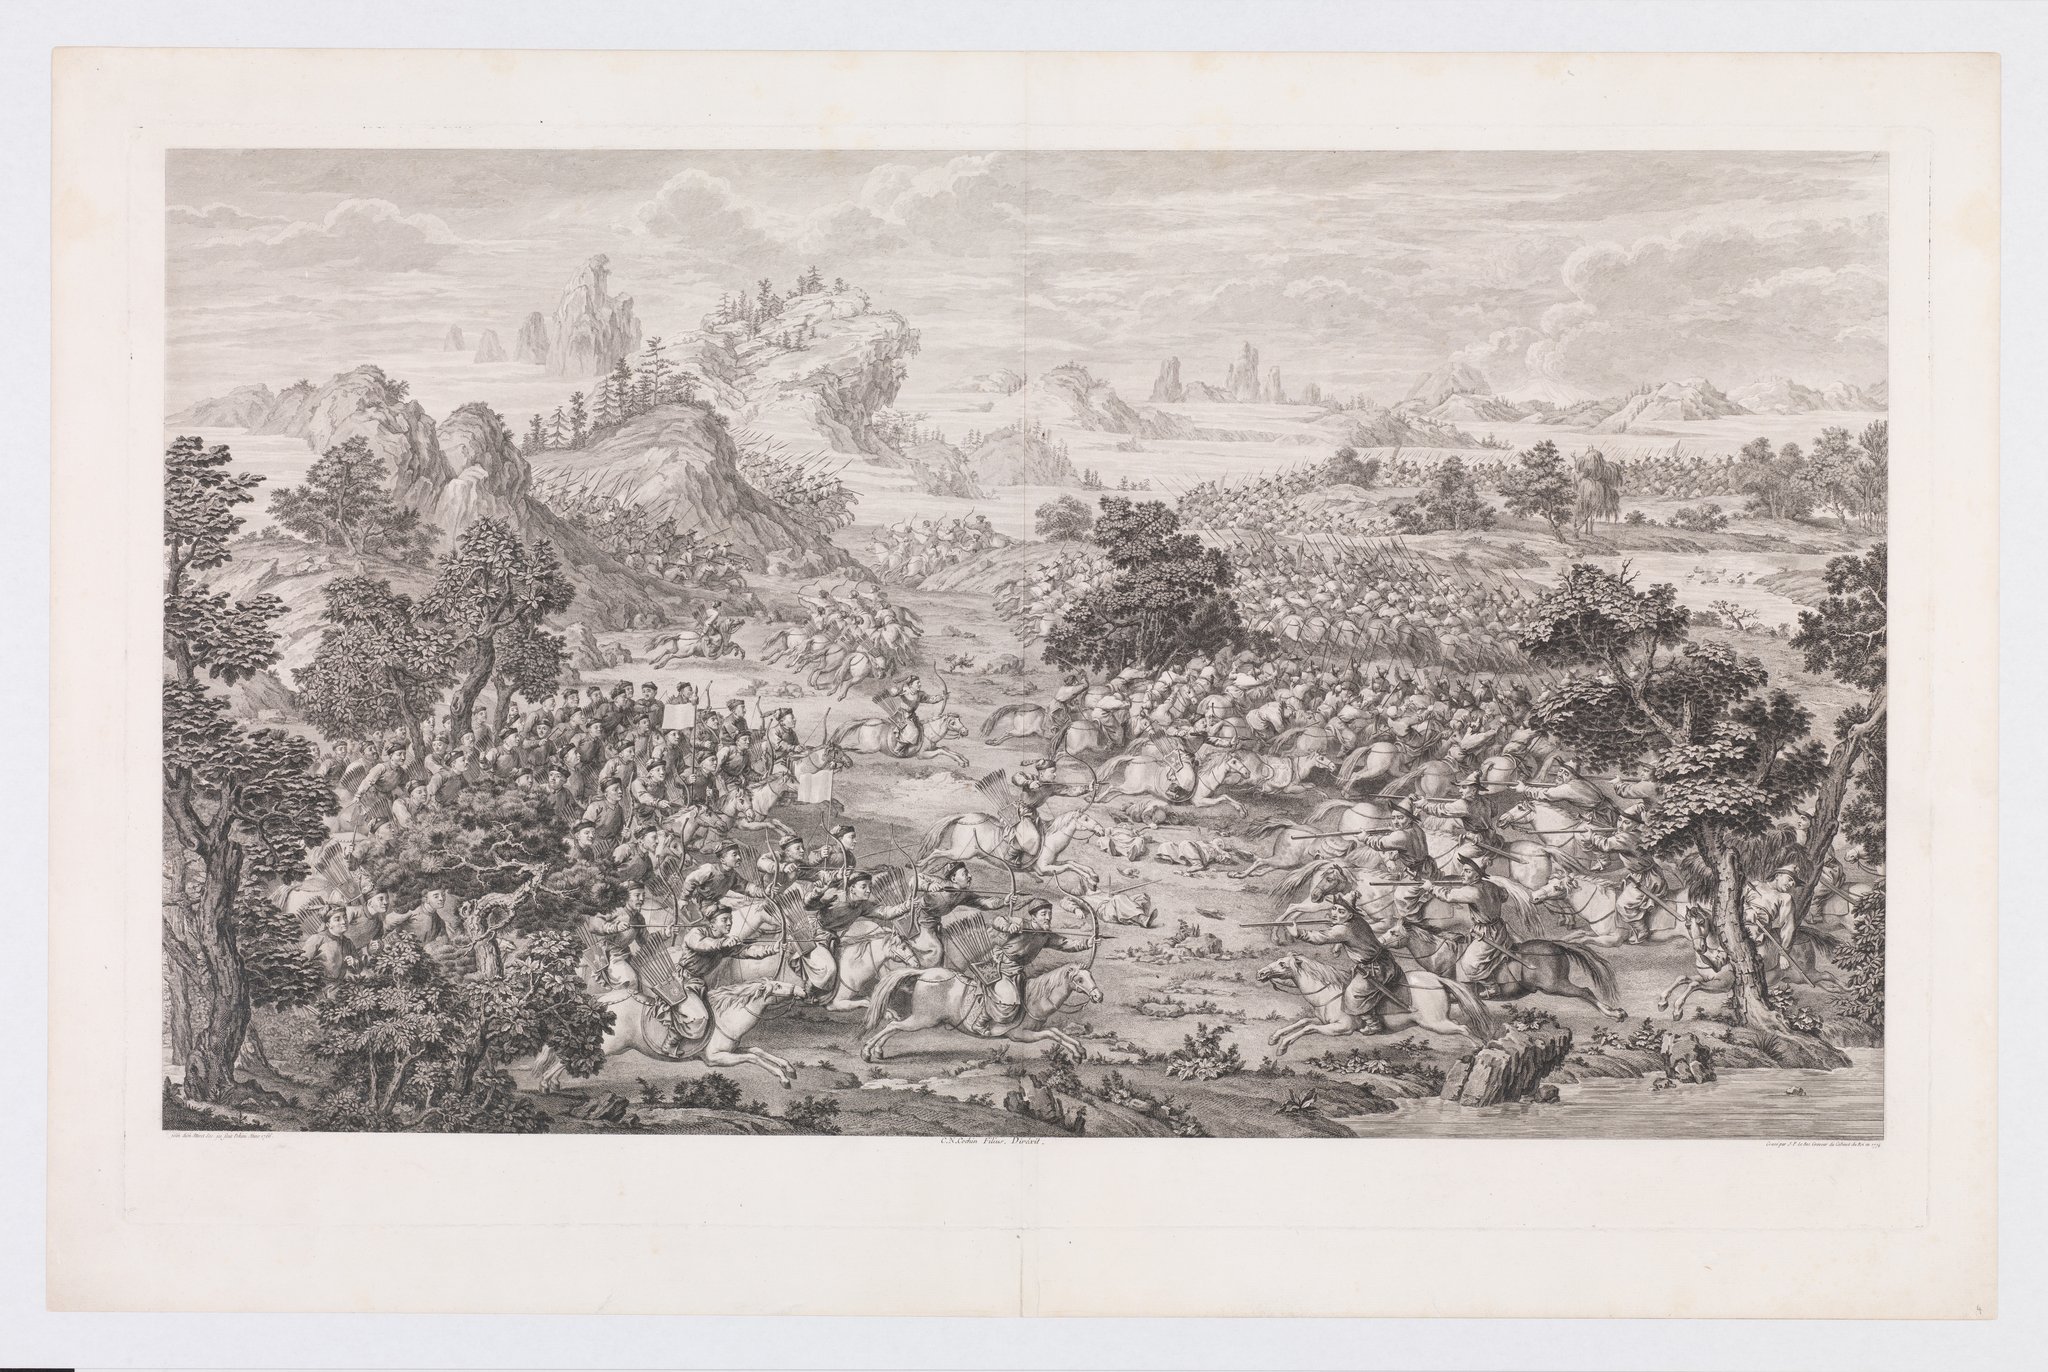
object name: print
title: The Victory of Khorgos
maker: jacques philippe le bas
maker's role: artist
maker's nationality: french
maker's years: 1707-1783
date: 1774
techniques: engraving, etching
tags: battles,soldiers,horses